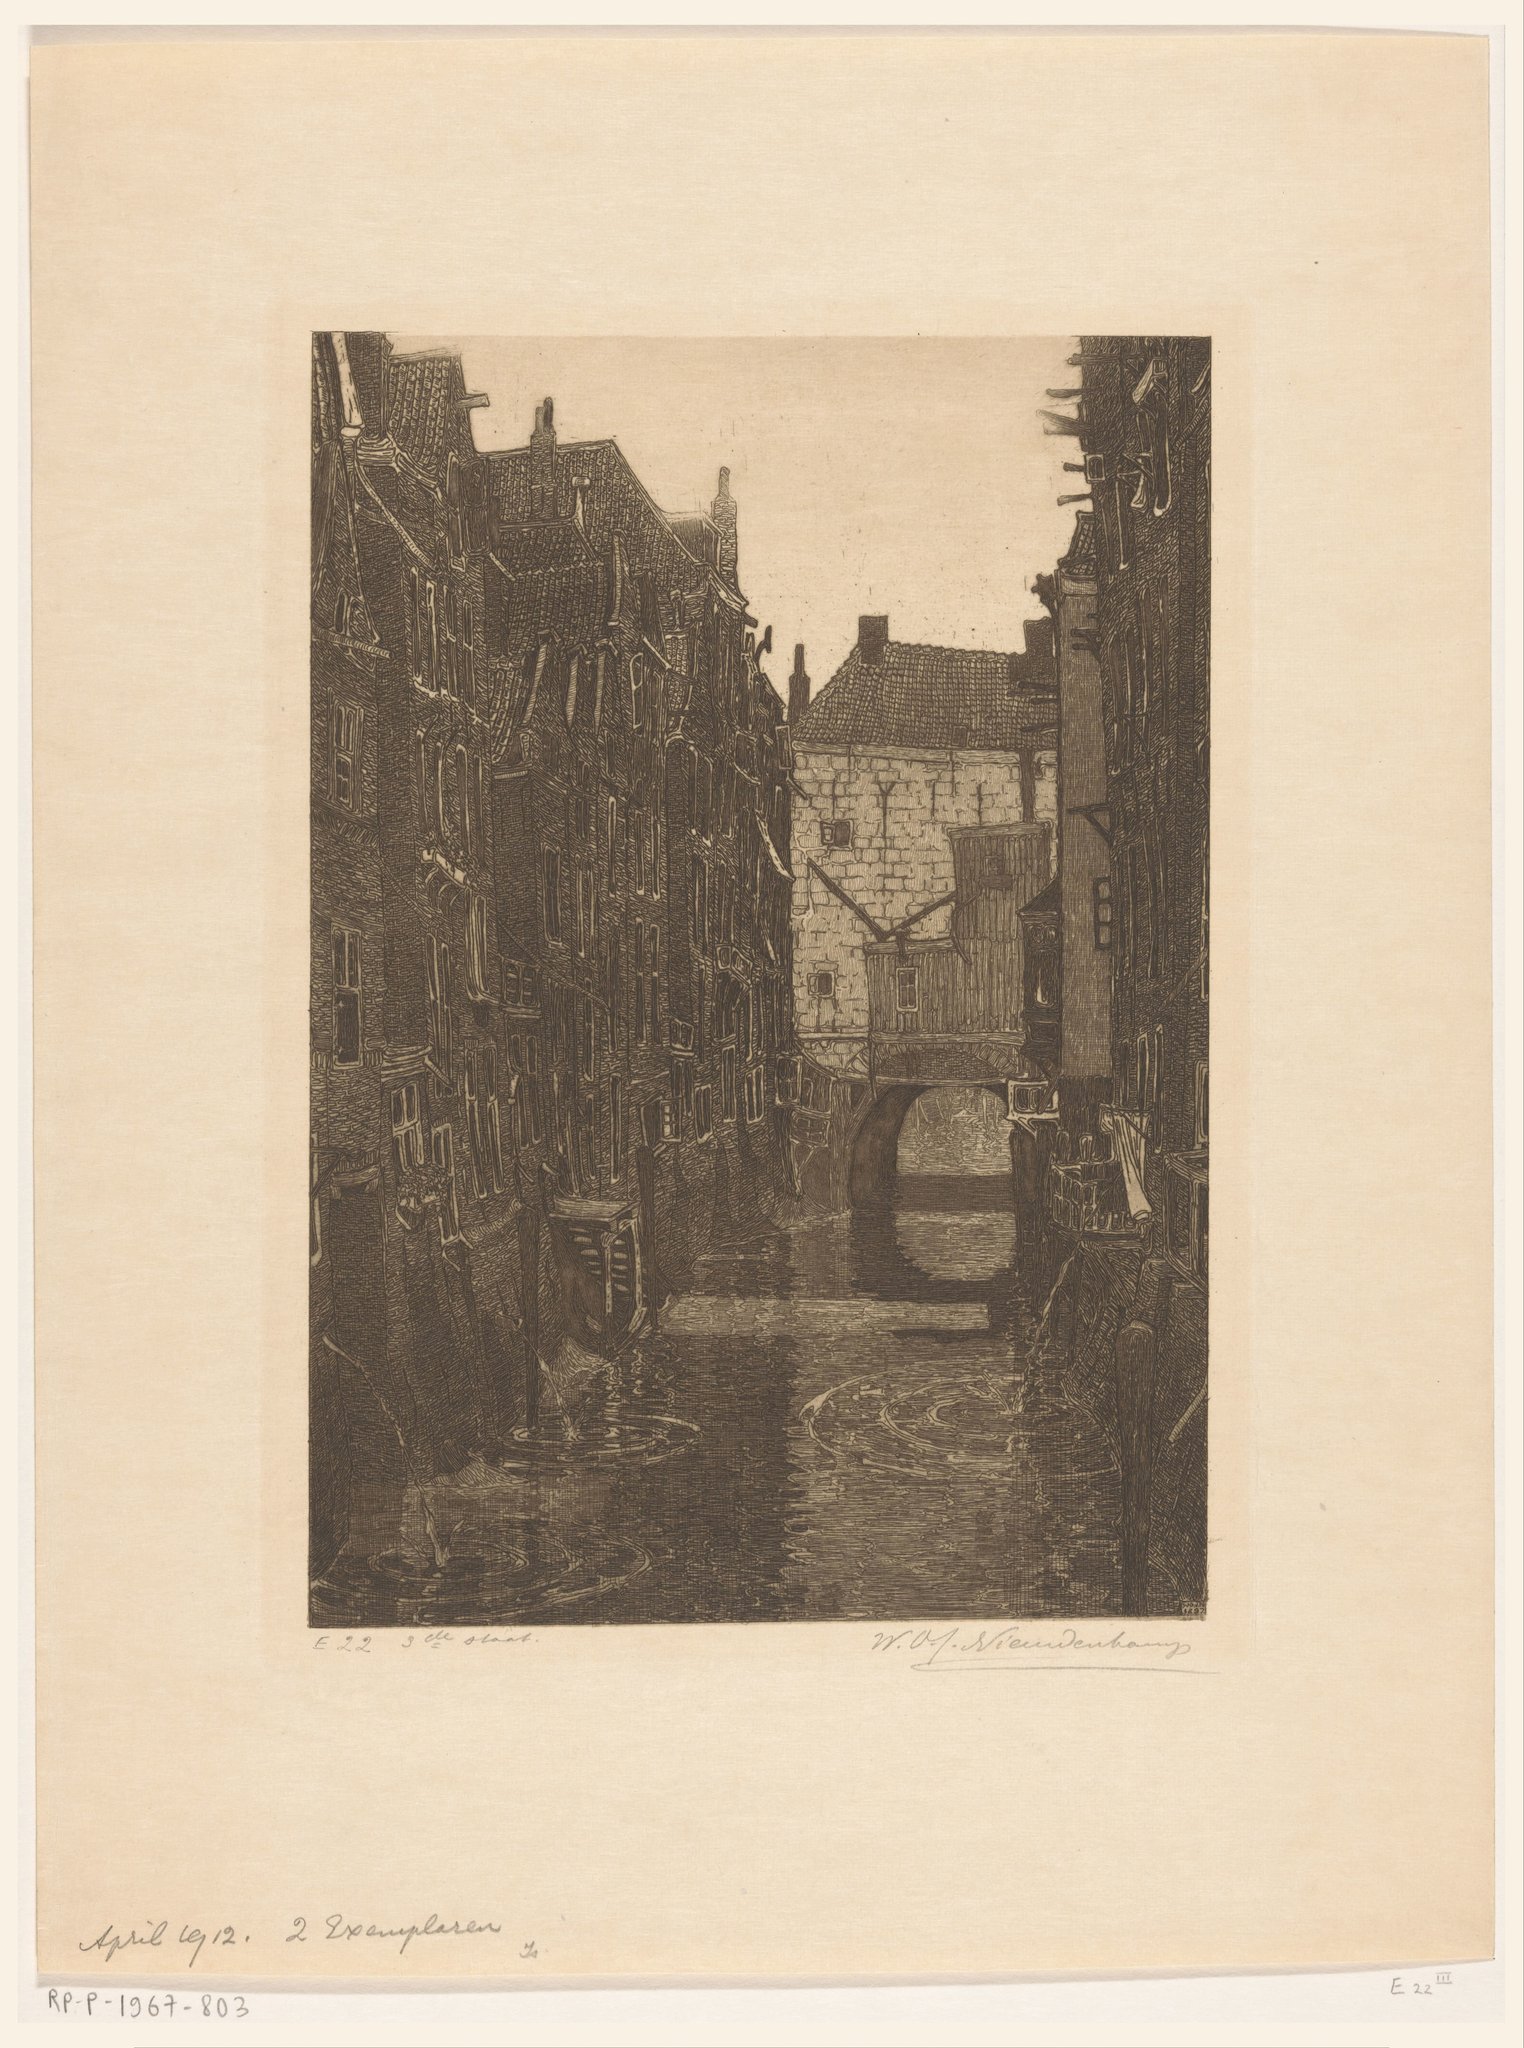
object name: print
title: Huizen aan de Voorstraatshaven in Dordrecht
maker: wijnand otto jan nieuwenkamp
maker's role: draughtsman, print maker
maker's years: 1874-1950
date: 1897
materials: paper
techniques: etching, intaglio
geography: amsterdam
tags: canals, waters (in city)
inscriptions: collector's mark: Lugt 2228, collector's mark: Lugt 2760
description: Op de achtergrond de achtergevel van het stadhuis van Dordrecht.